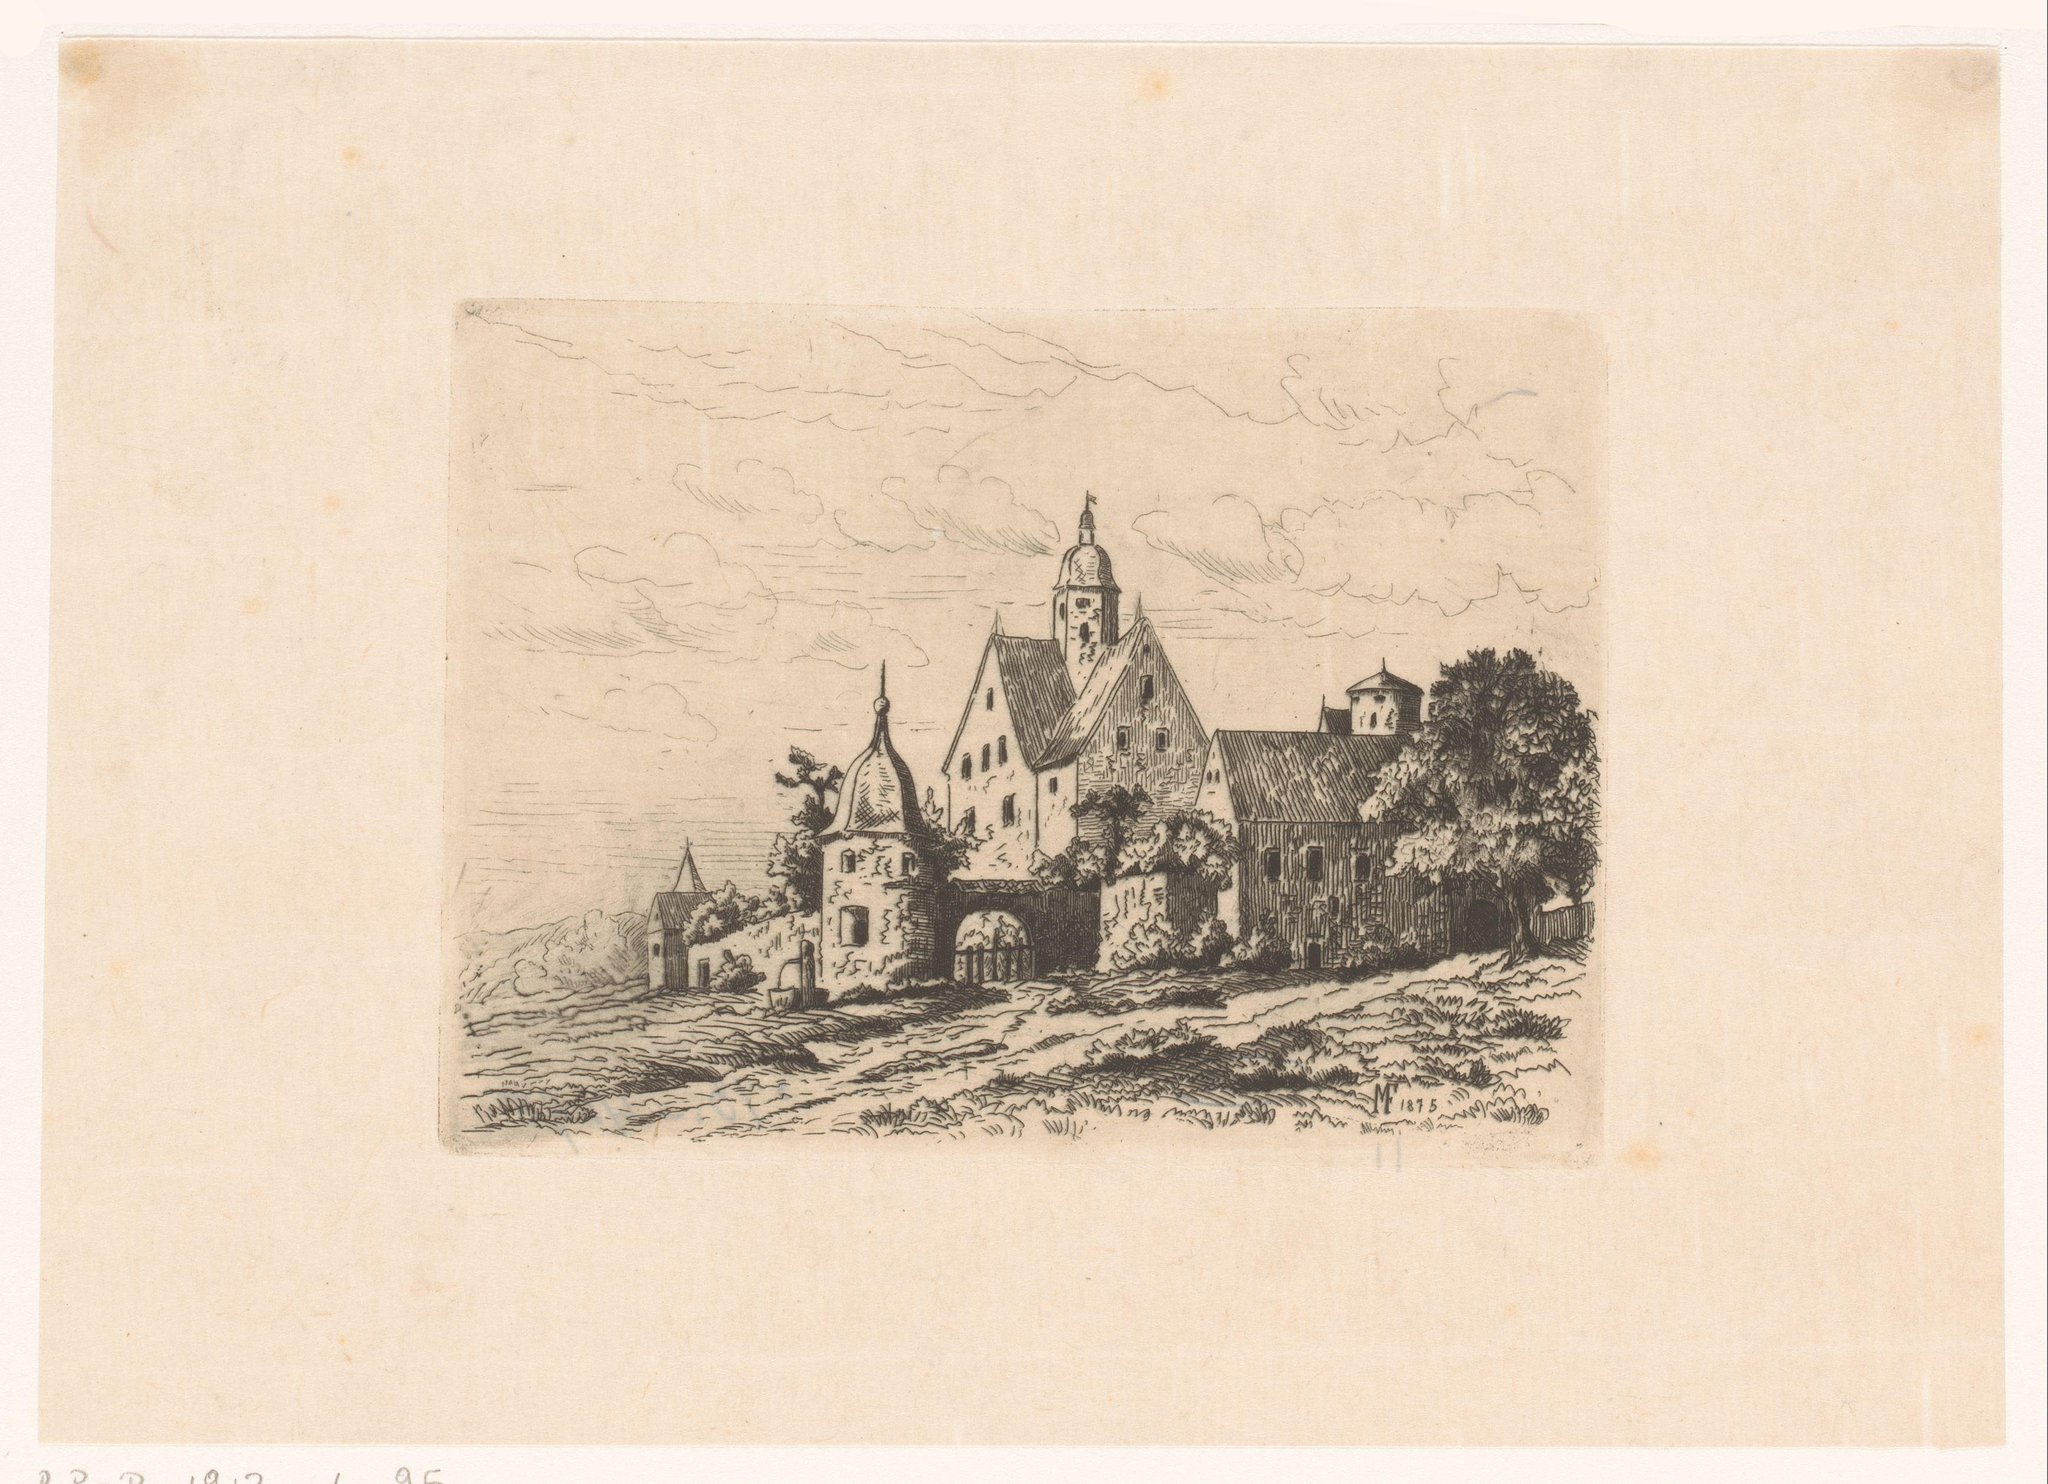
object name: print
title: Gezicht op een kasteel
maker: maria van hohenzollern-sigmaringen (gravin van vlaanderen)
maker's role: print maker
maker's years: 1845-1912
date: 1875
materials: paper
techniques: etching, intaglio, retroussage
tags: landscape with tower or castle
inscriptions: collector's mark: Lugt 2228